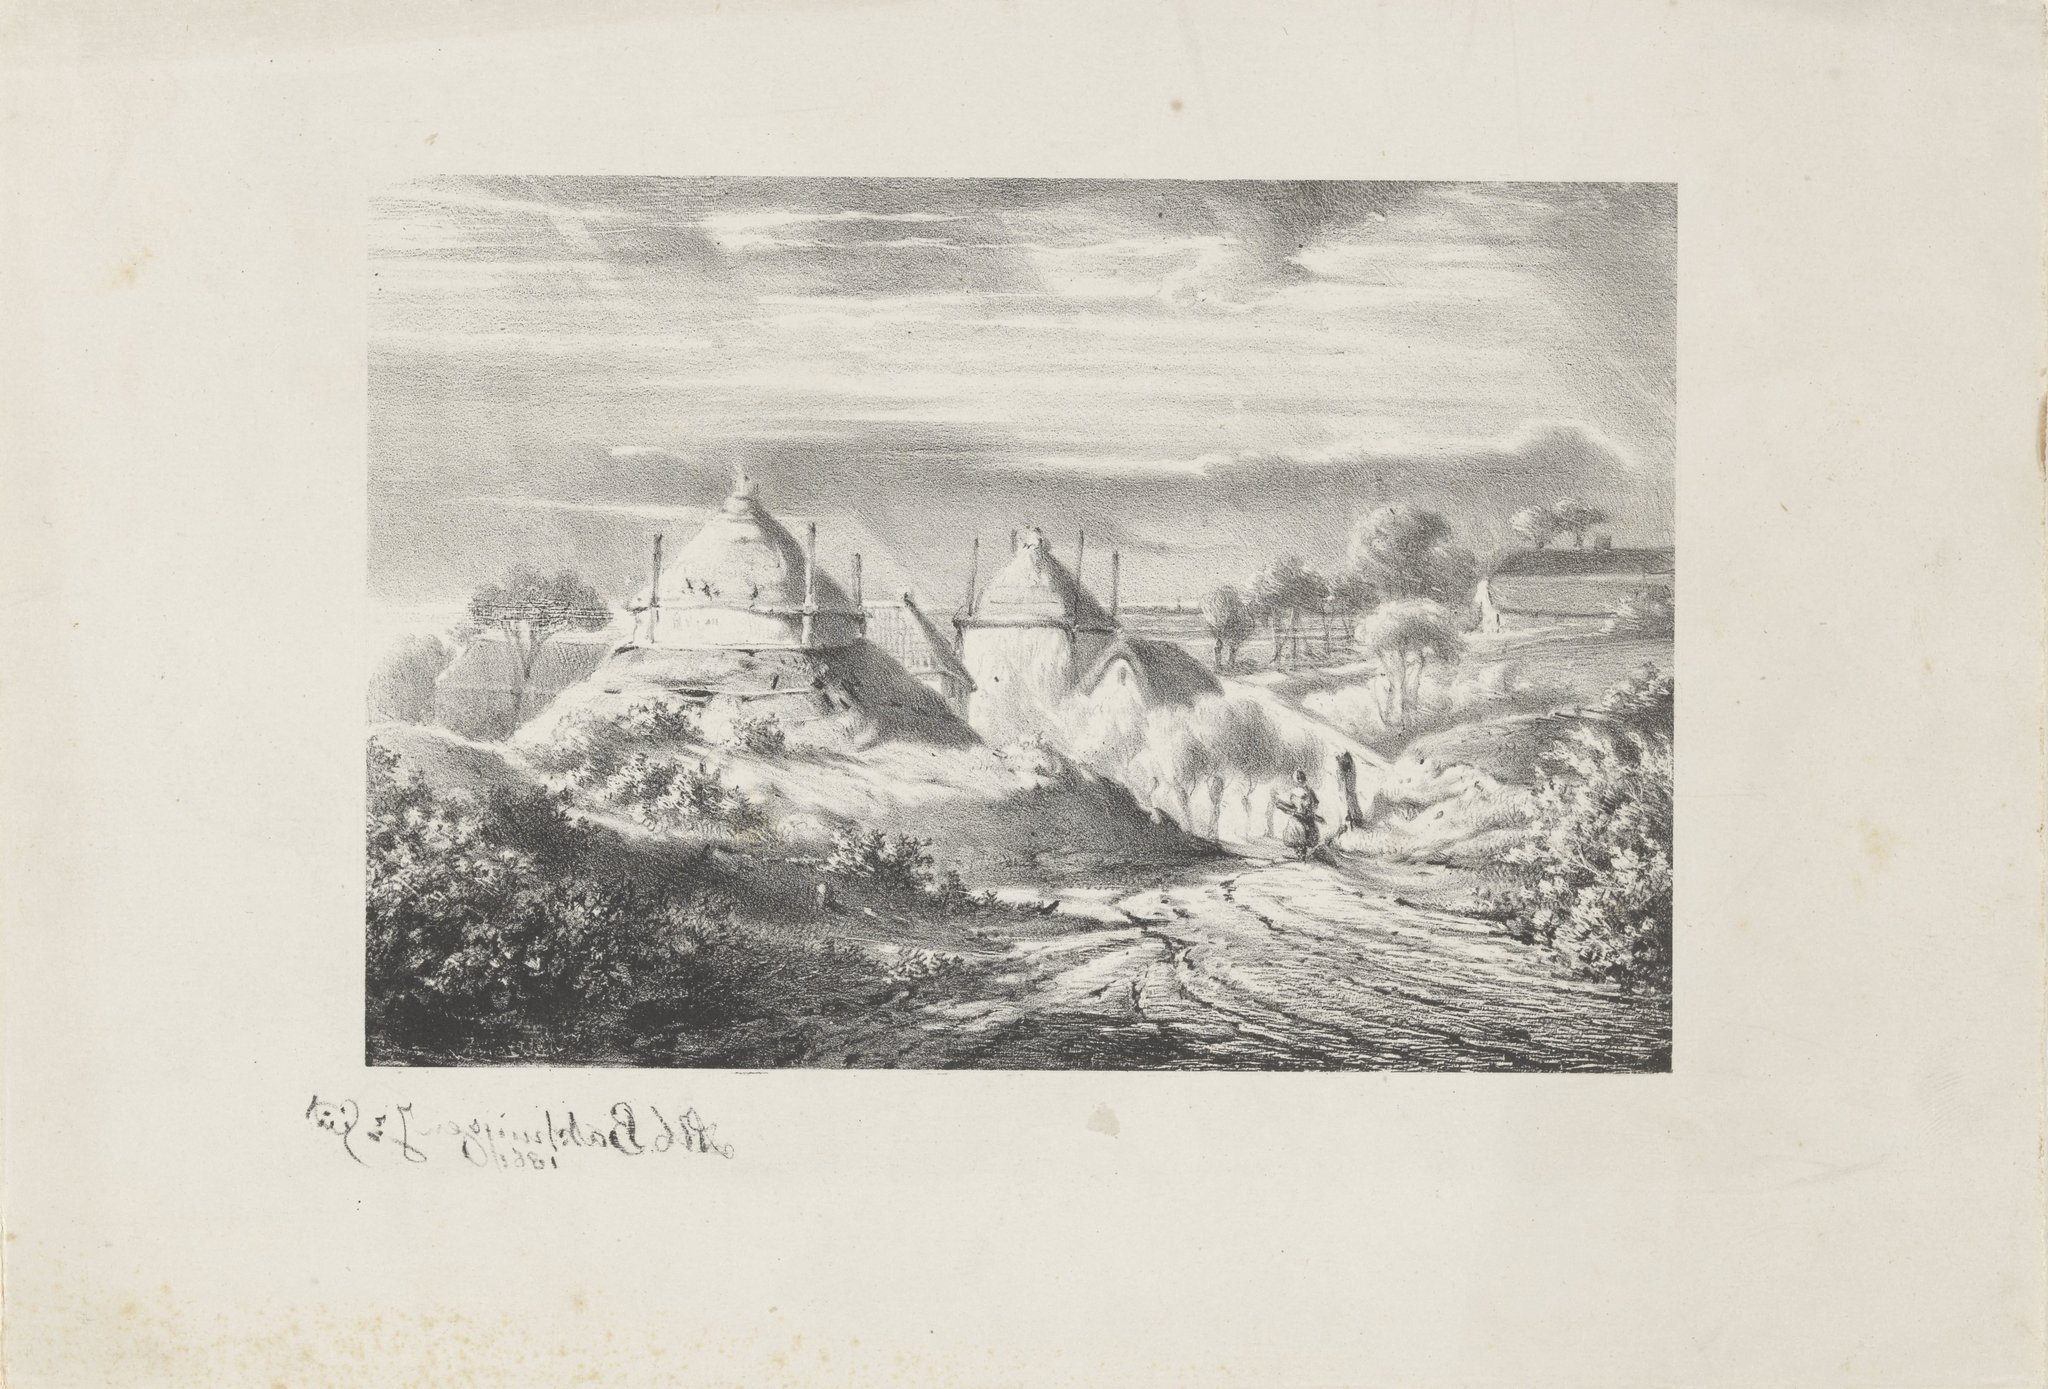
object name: print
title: Hooibergen en boerderijen aan een landweg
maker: alexander hieronymus bakhuyzen (ii)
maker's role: print maker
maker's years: 1826-1878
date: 1861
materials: paper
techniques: lithograph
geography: netherlands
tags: hay-stack, landscapes (+ landscape with figures, staffage), farm (building)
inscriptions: collector's mark: Lugt 2228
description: Aan een landweg liggen hooibergen met daartussen boerderijen. Op de weg loopt een figuur. Zonlicht breekt door de wolken.